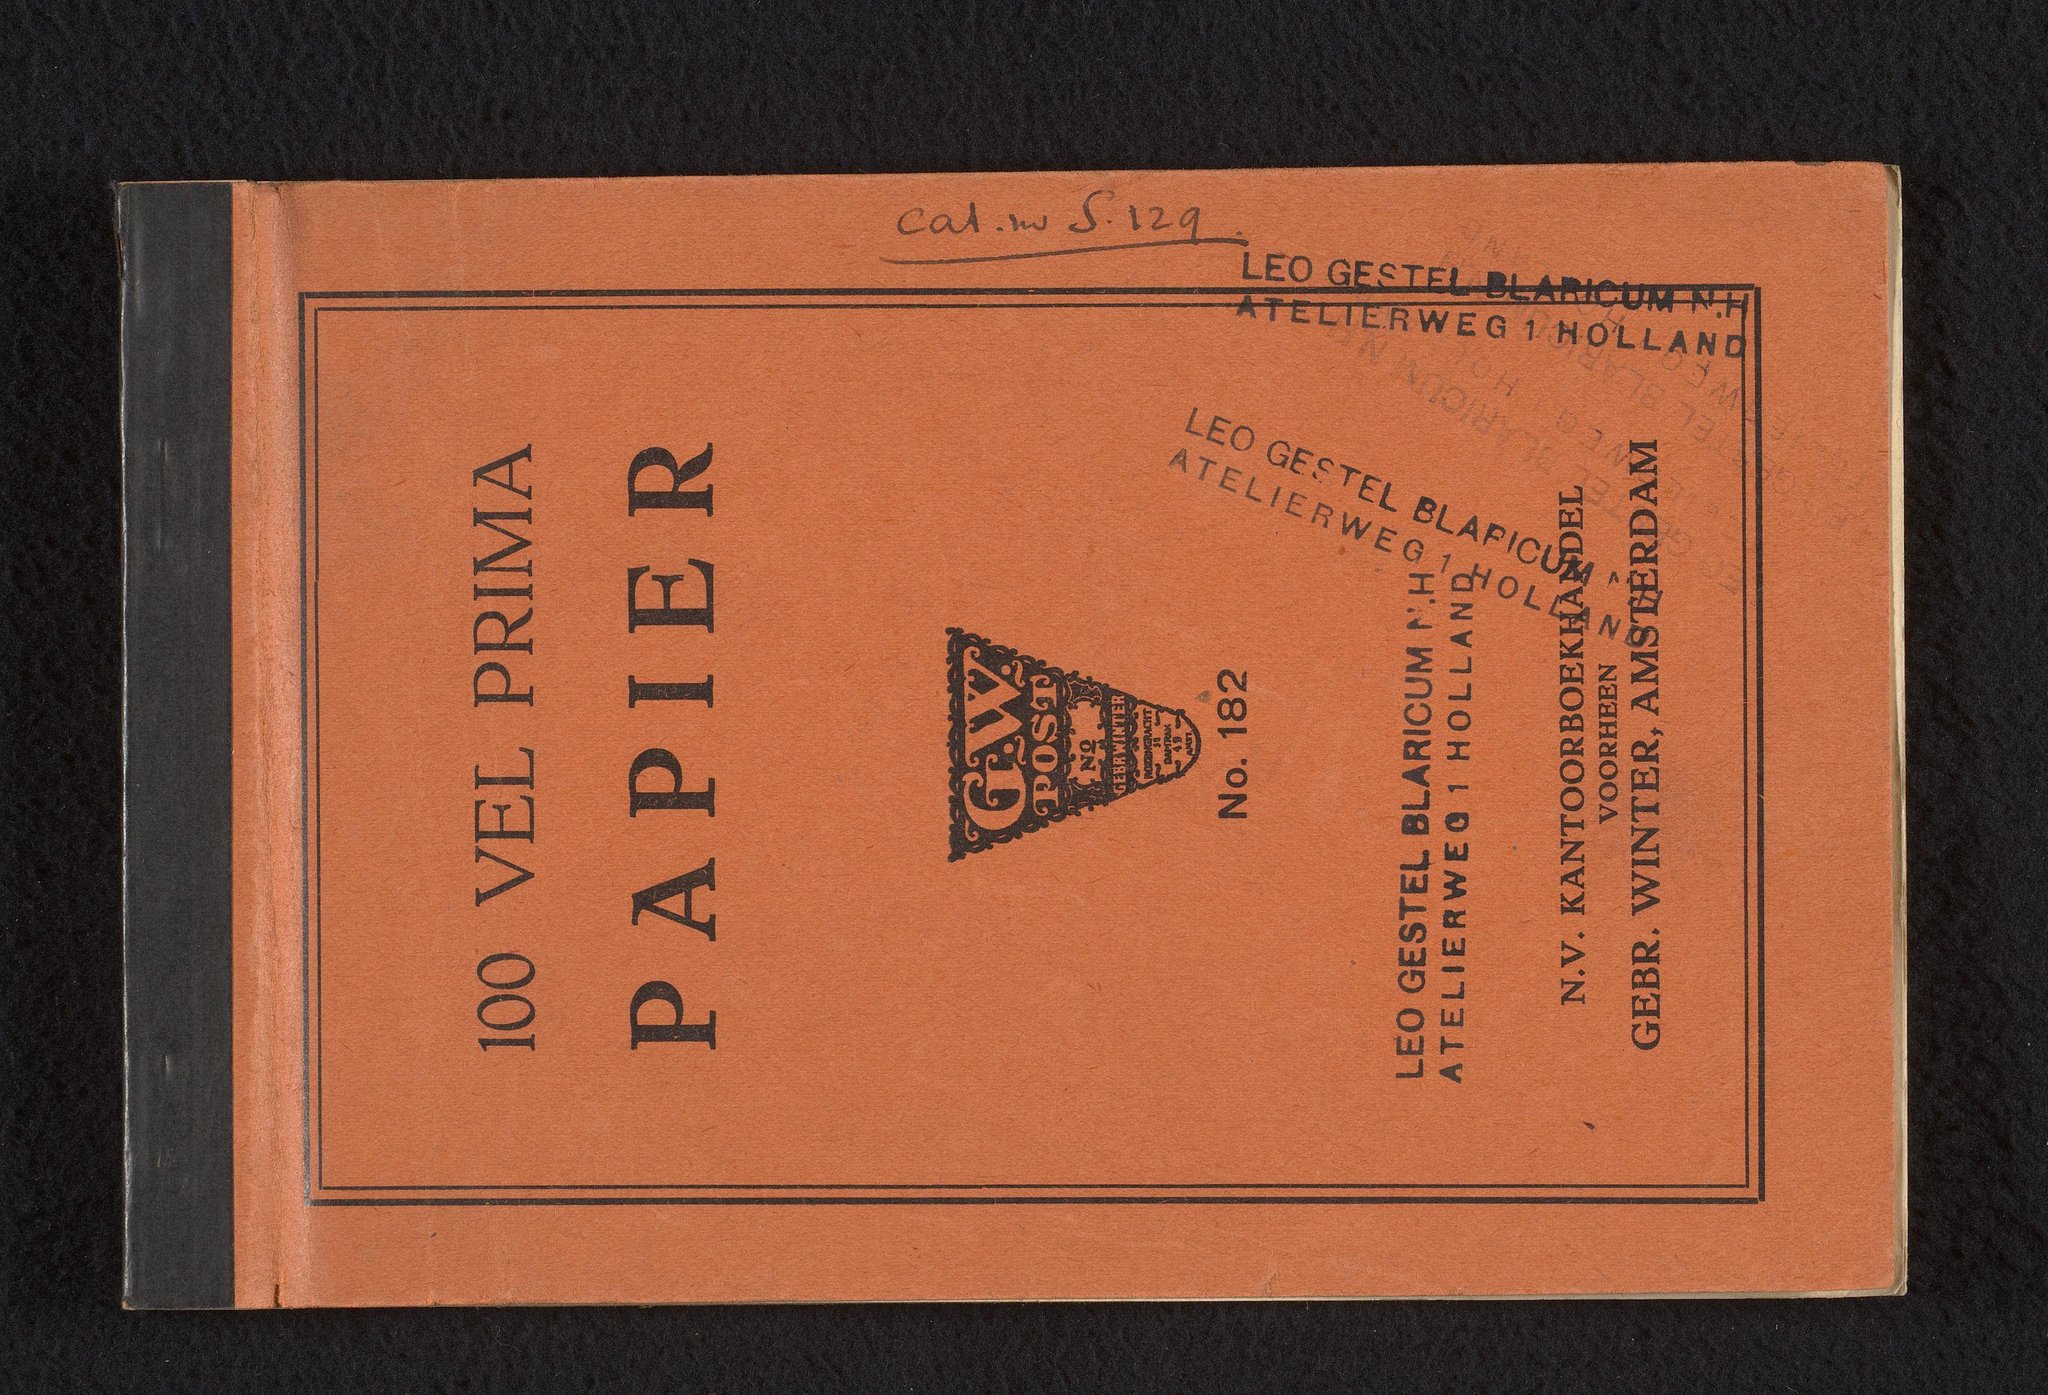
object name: sketchbook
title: Schetsboek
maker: leo gestel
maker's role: draughtsman, print maker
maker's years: 1881-1941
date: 1941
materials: chalk, ink, paper, pencil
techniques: drawing, pen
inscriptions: workshop stamp: ‘LEO GESTEL BLARICUM N.H./ ATELIERWEG 1 HOLLAND’, inscription: ‘Schetsboek 4 bladen eenzijdig beteekend’, workshop stamp: Lugt 1078a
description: Schetsboek met vier schetsen van boeren die een maaltijd nuttigen op het land.